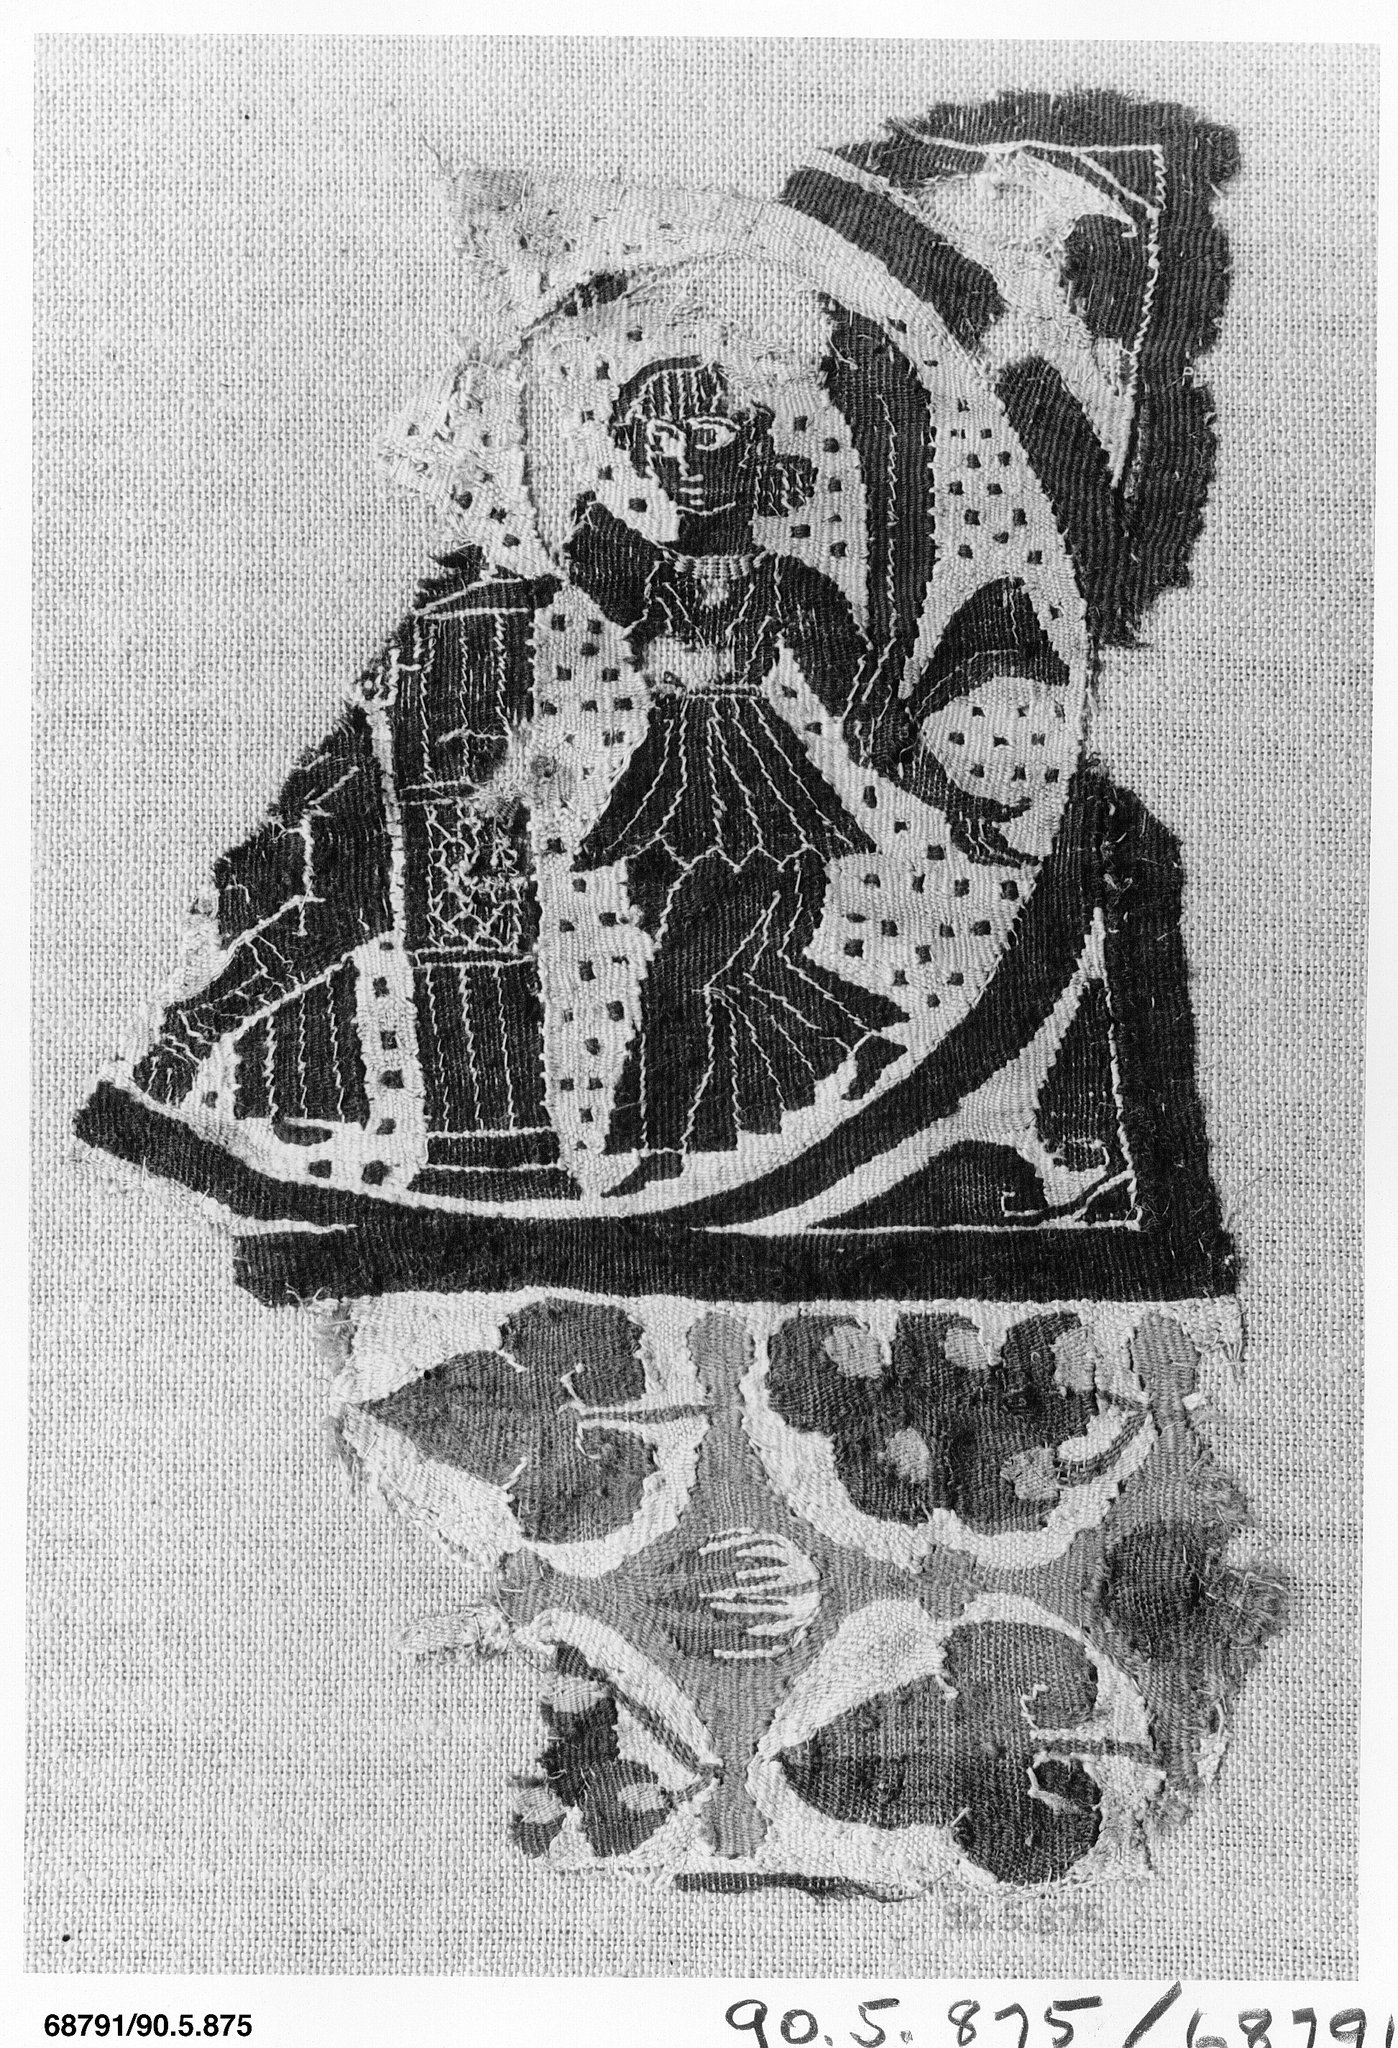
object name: panel fragment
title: Fragment with Two Figures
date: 401-600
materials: linen, wool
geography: egypt